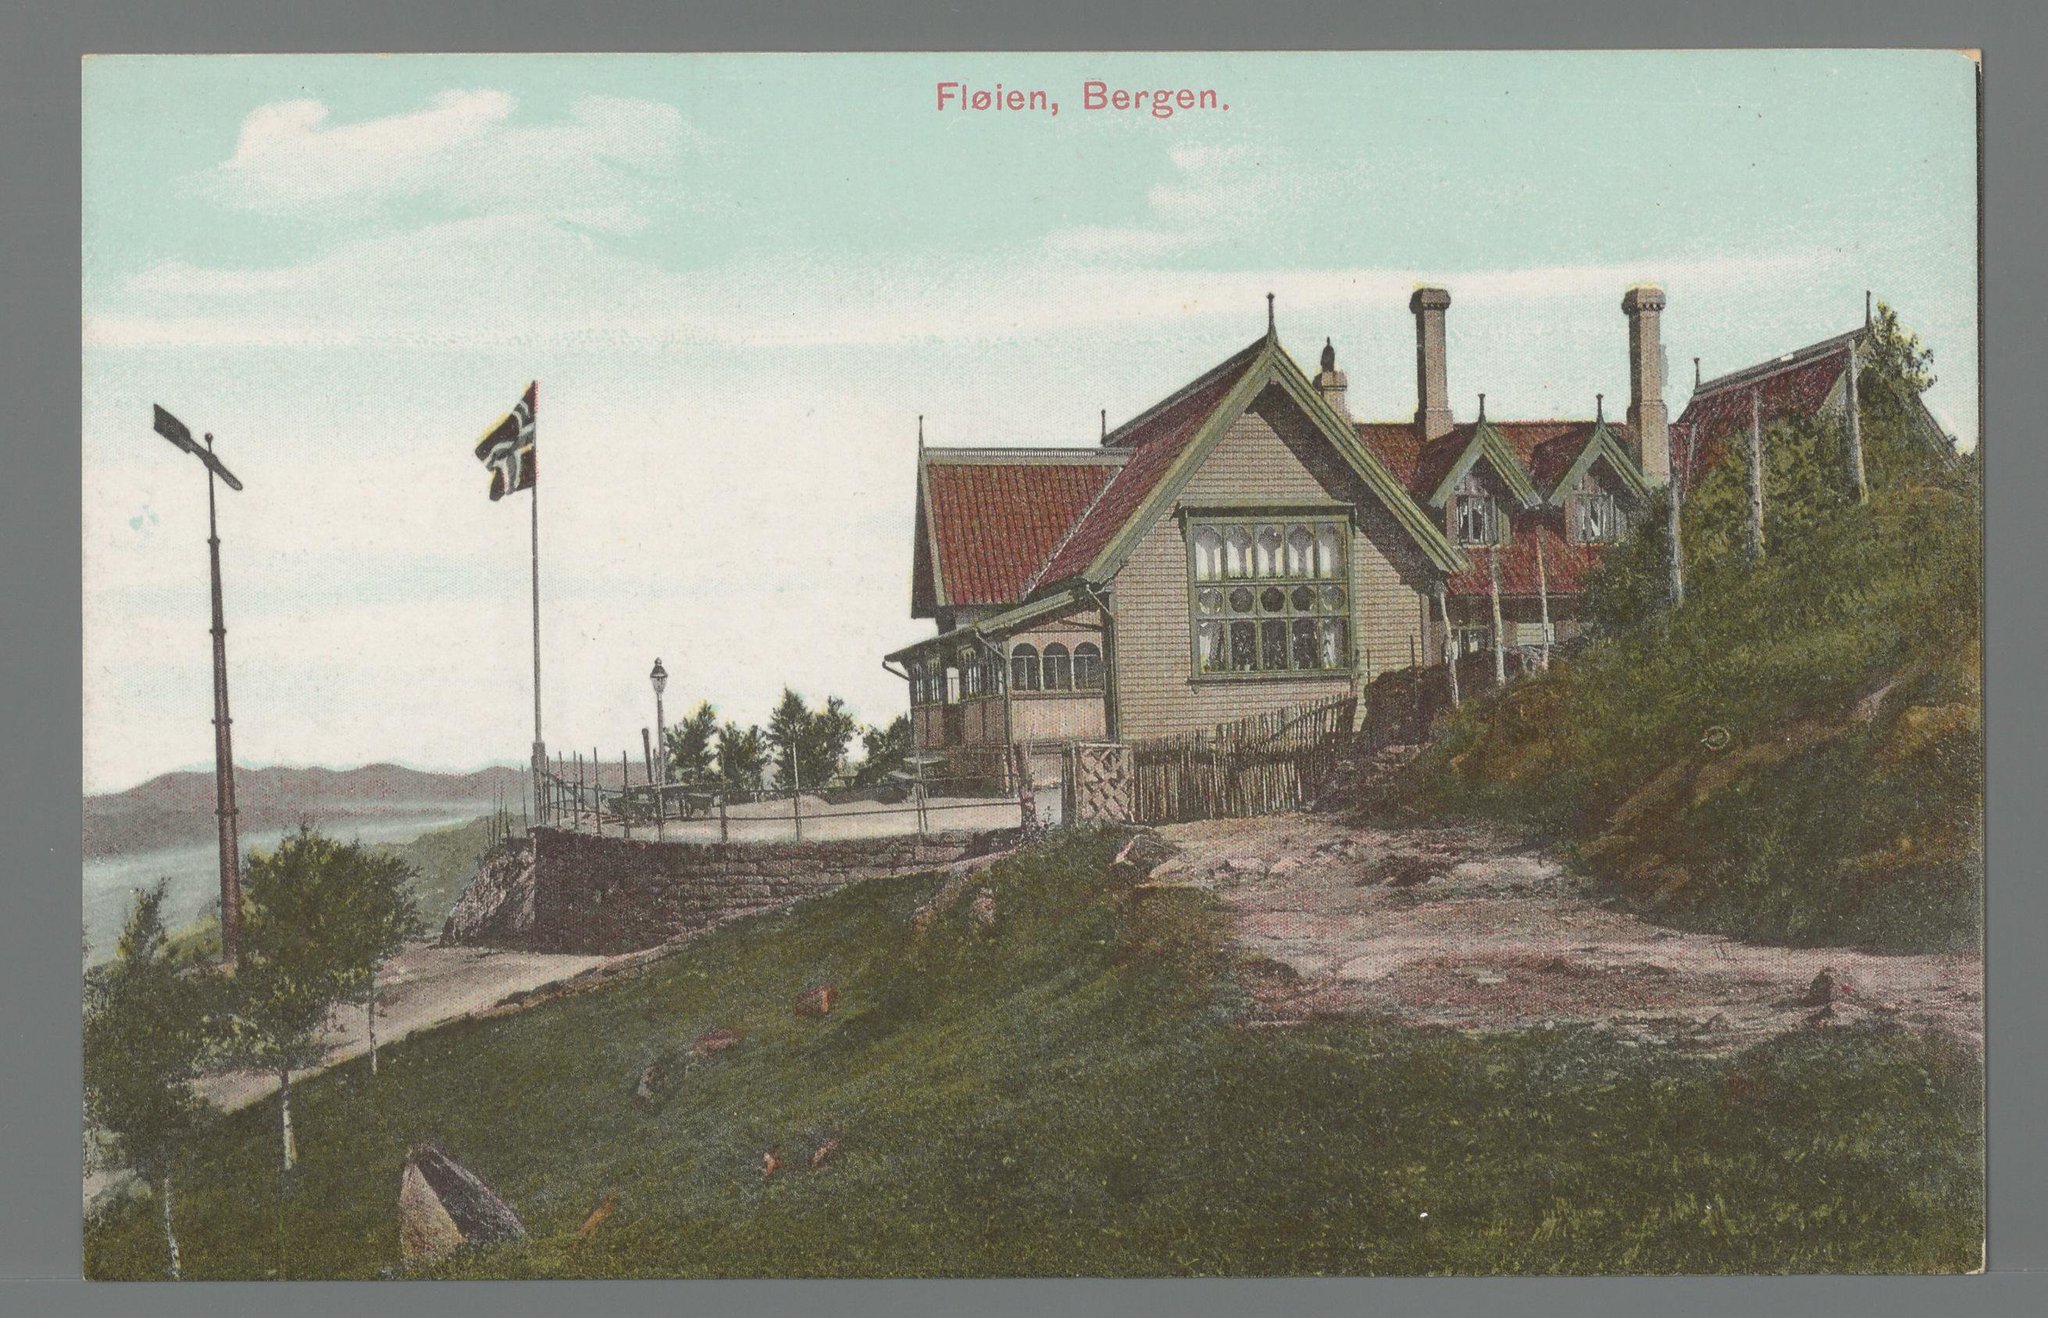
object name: ansichtkaart, prentbriefkaart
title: Fløien, Bergen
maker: Anonymous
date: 1904-1930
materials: cardboard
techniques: photograph, lithograph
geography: bergen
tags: mountain-top, peak